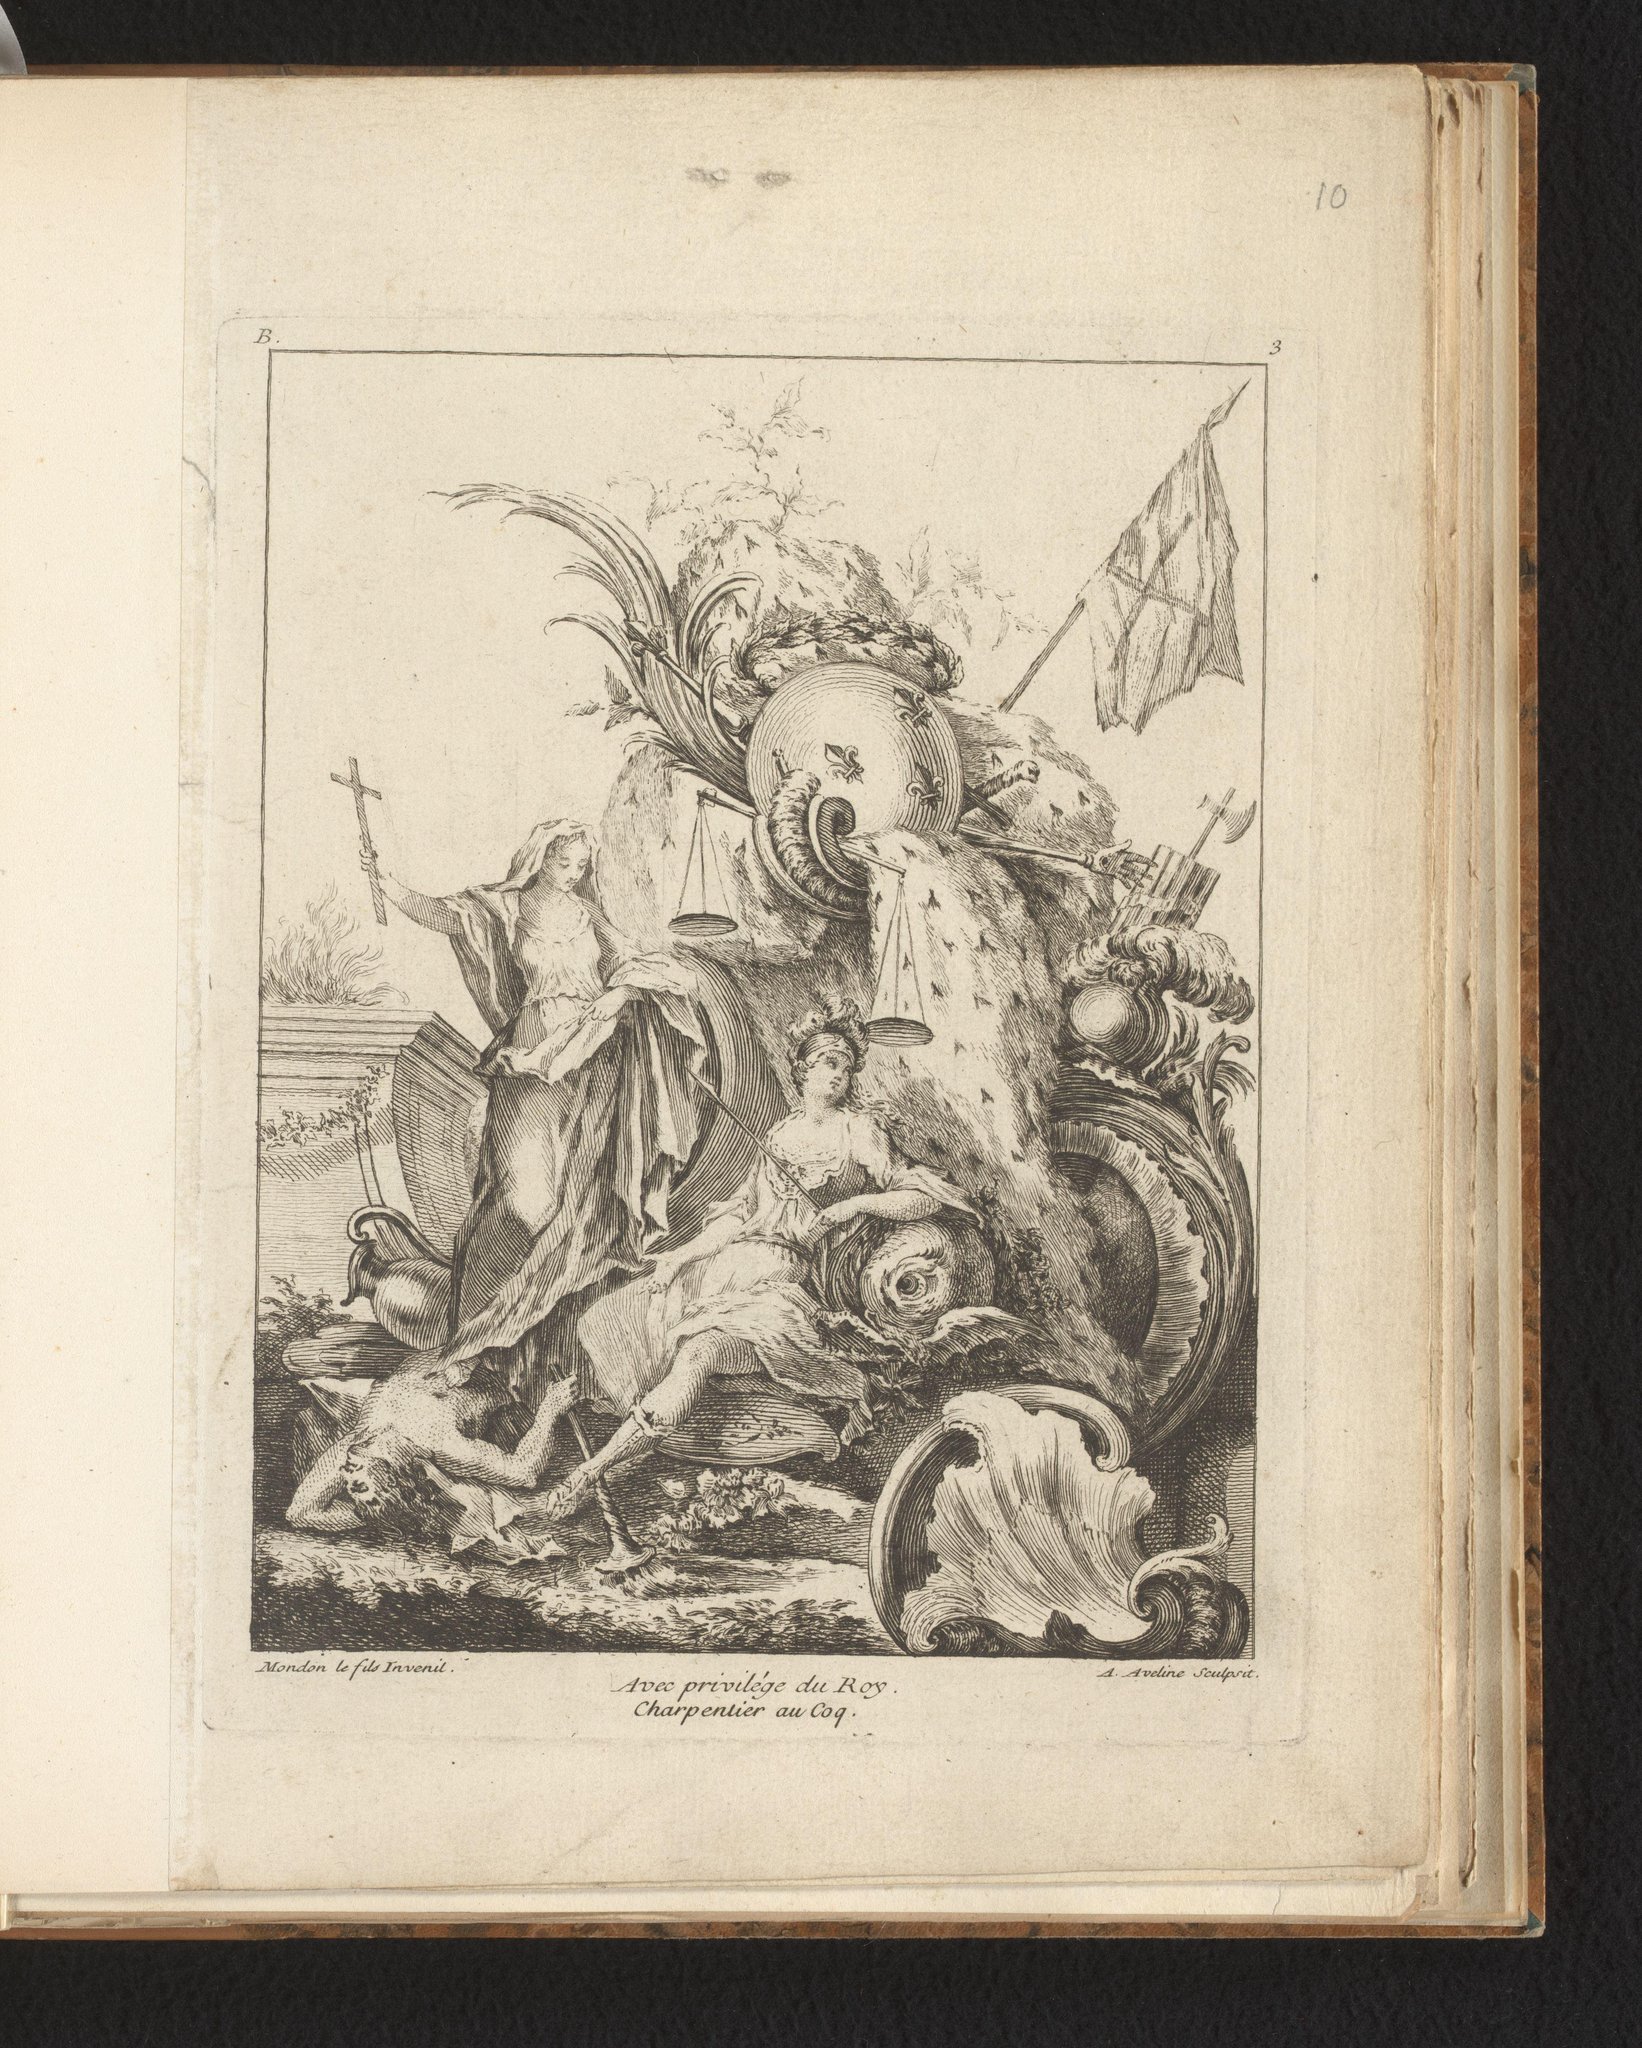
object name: print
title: Serie van trofeeën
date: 1736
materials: paper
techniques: etching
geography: paris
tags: rocaille ornament, personifications of countries, nations, states, districts, etc., the church personified, 'ecclesia', usually with chalice and banner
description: Deze serie is linksboven genummerd met een letter B. Prent maakt deel uit van een album.